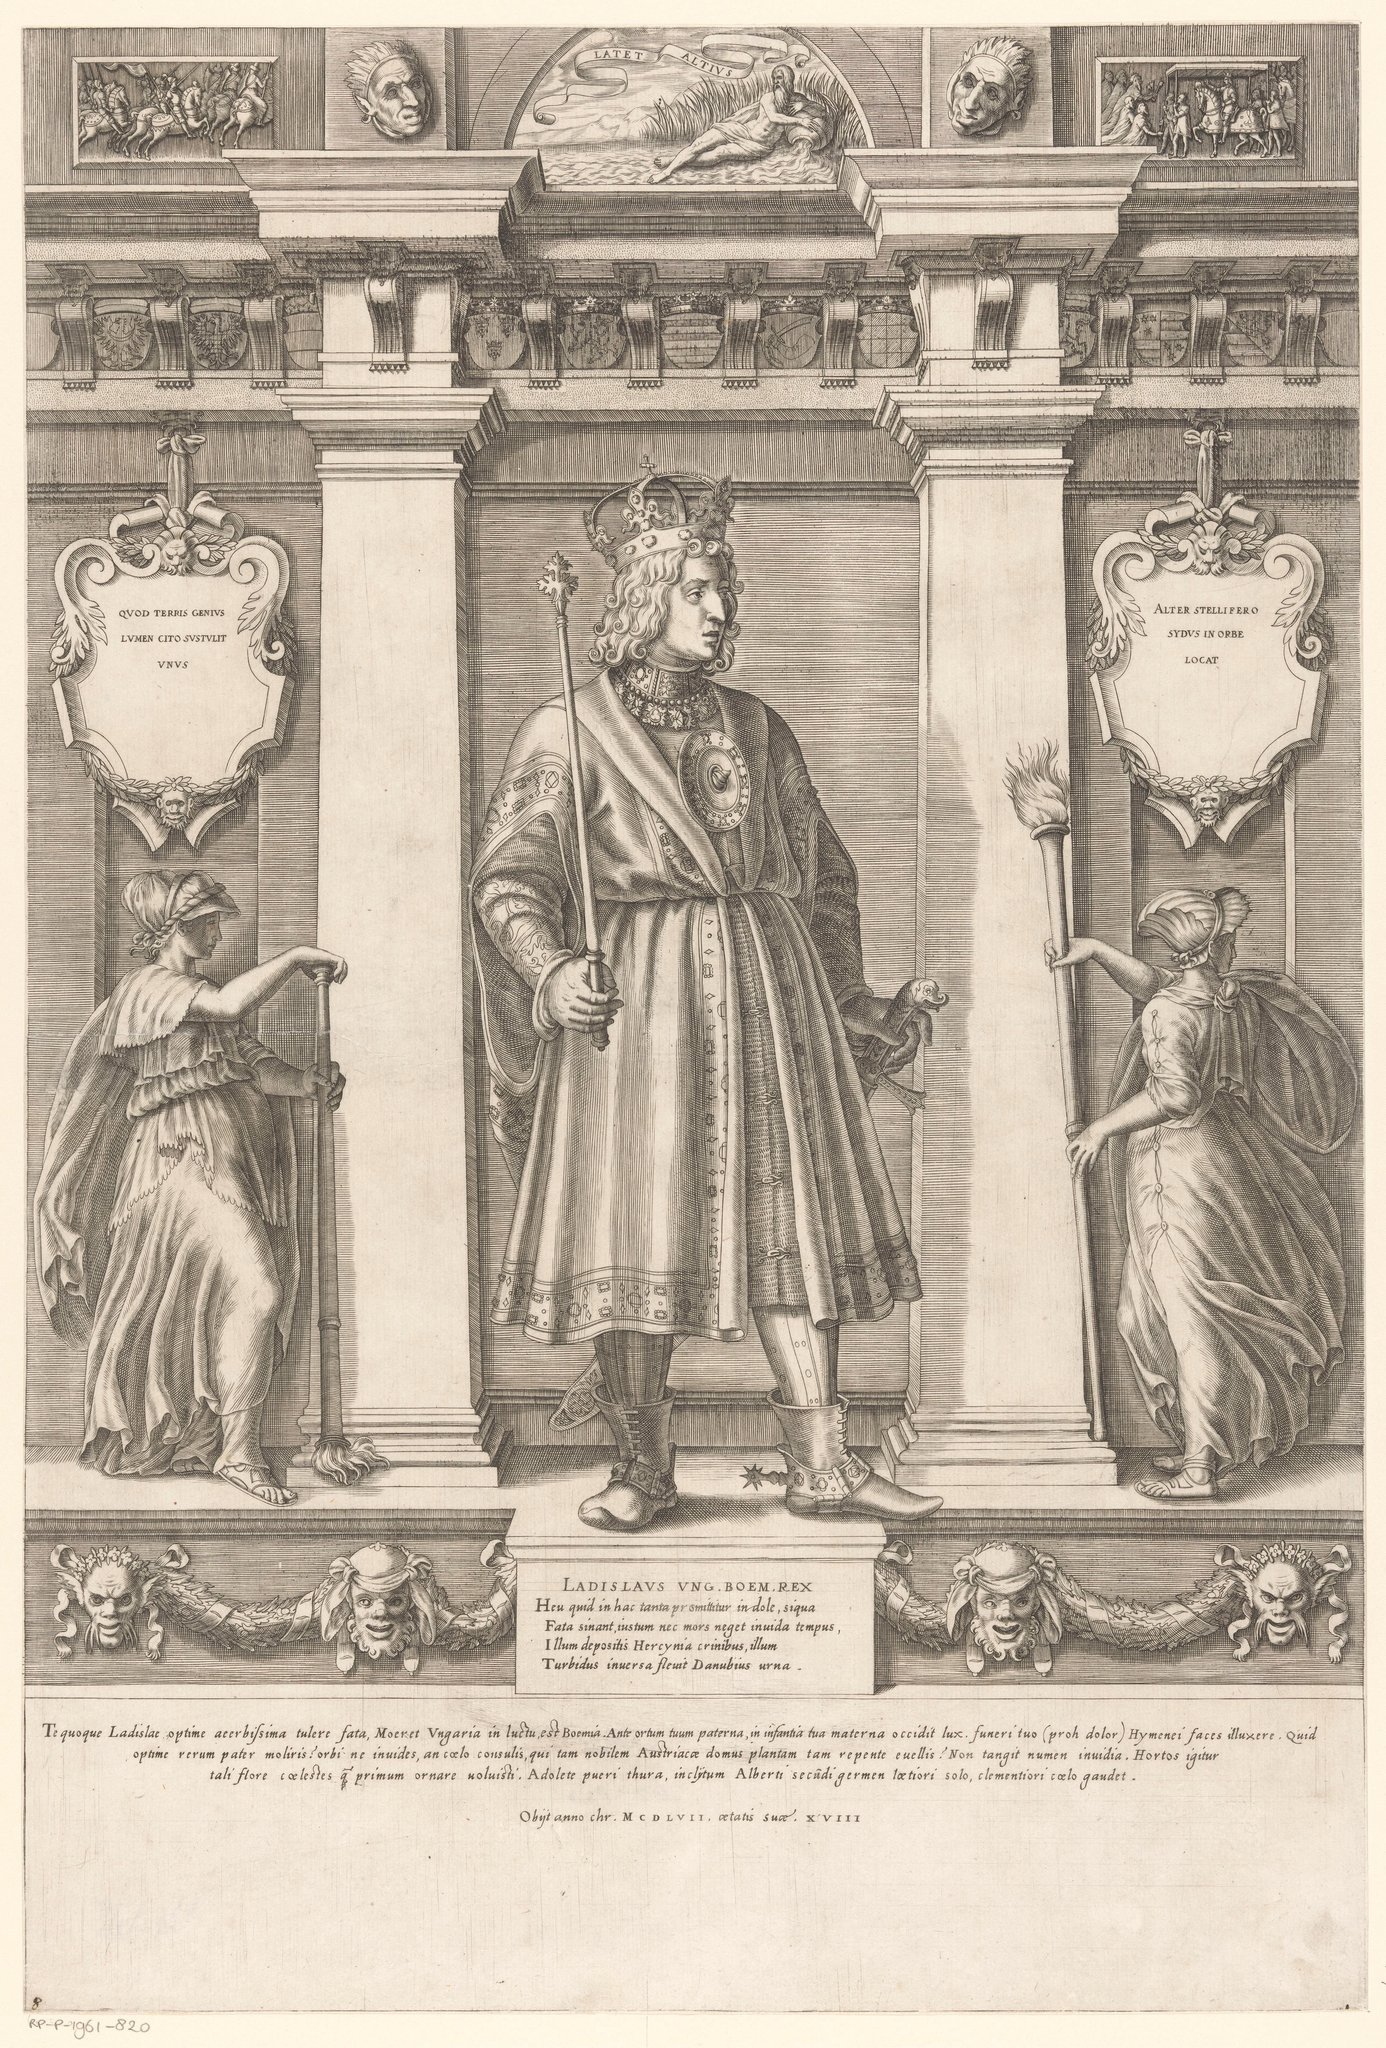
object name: print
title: Austriacae gentis imaginum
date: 1569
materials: paper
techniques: engraving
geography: italy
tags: historical persons, ruler, sovereign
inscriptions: collector's mark: Lugt 2228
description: Deze prent maakt deel uit van een reeks van 58 prenten. Het meerendeel van de prenten bevat portretten van 74 leden van het Oostenrijkse Huis, naar tekeningen door Francesco Terzio, die deels getekend zijn naar de 28 levensgrote bronzen beelden die rond de cenotaaf van Maximiliaan I in de Hofkirche te Innsbruck staan.